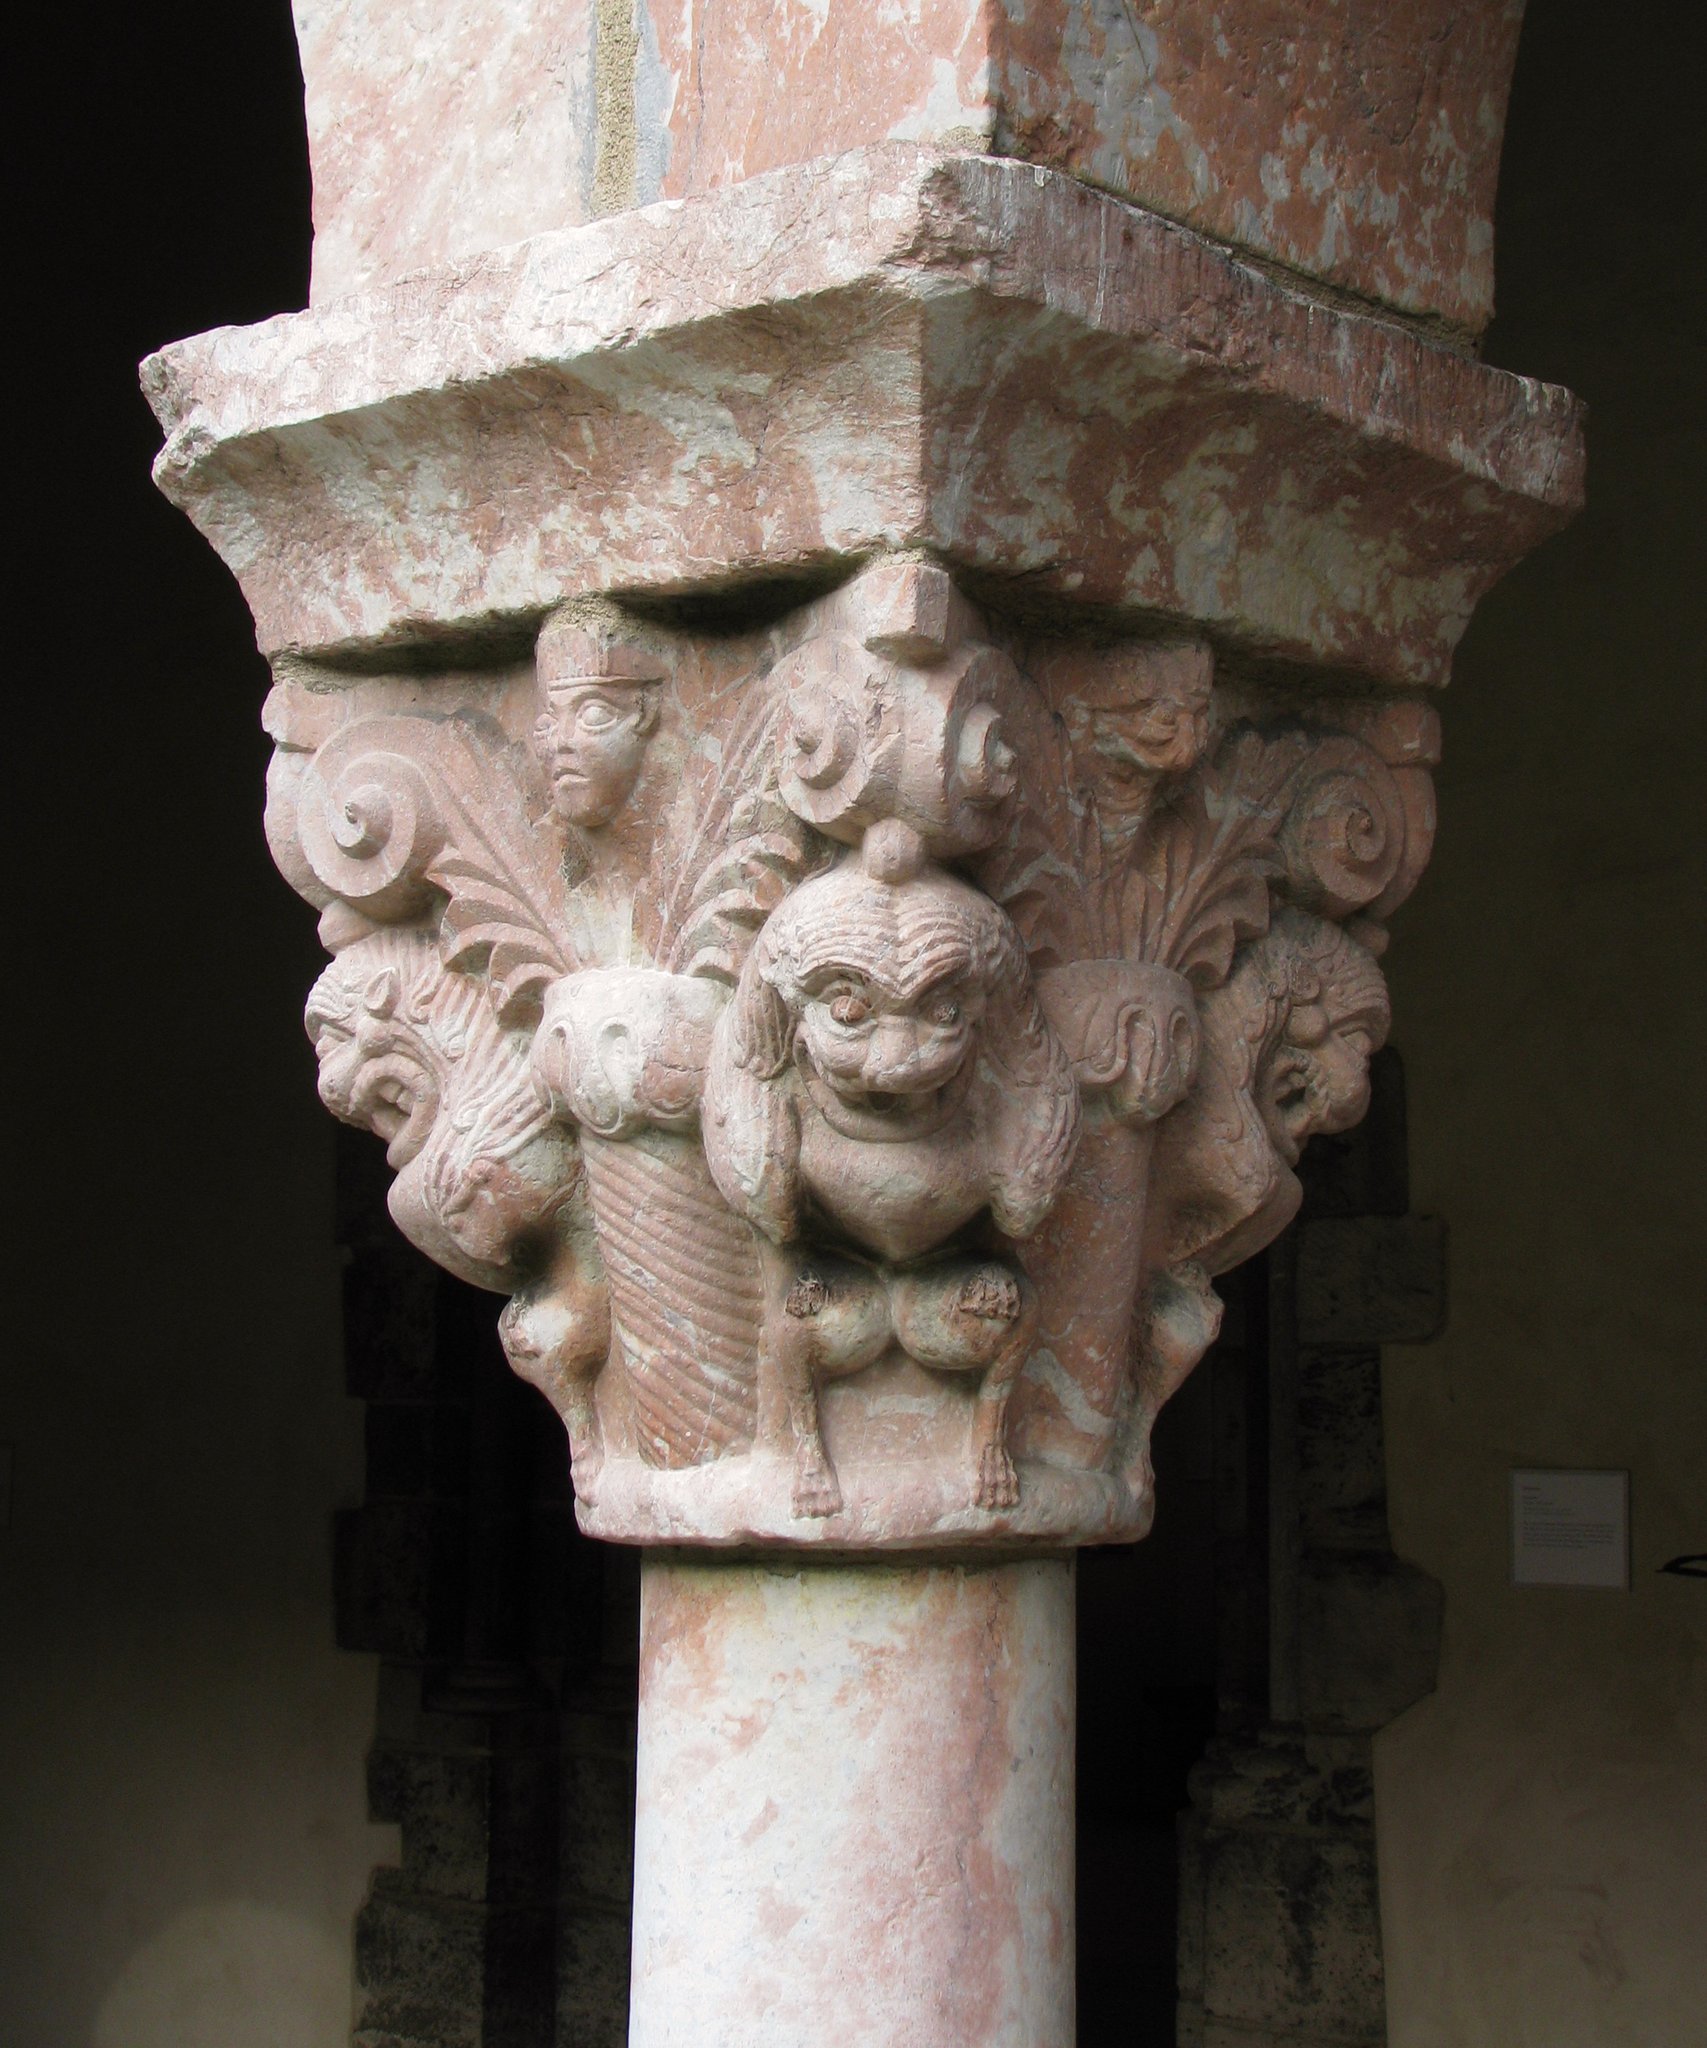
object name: capital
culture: catalan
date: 1130-1140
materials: marble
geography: france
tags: mythical creatures